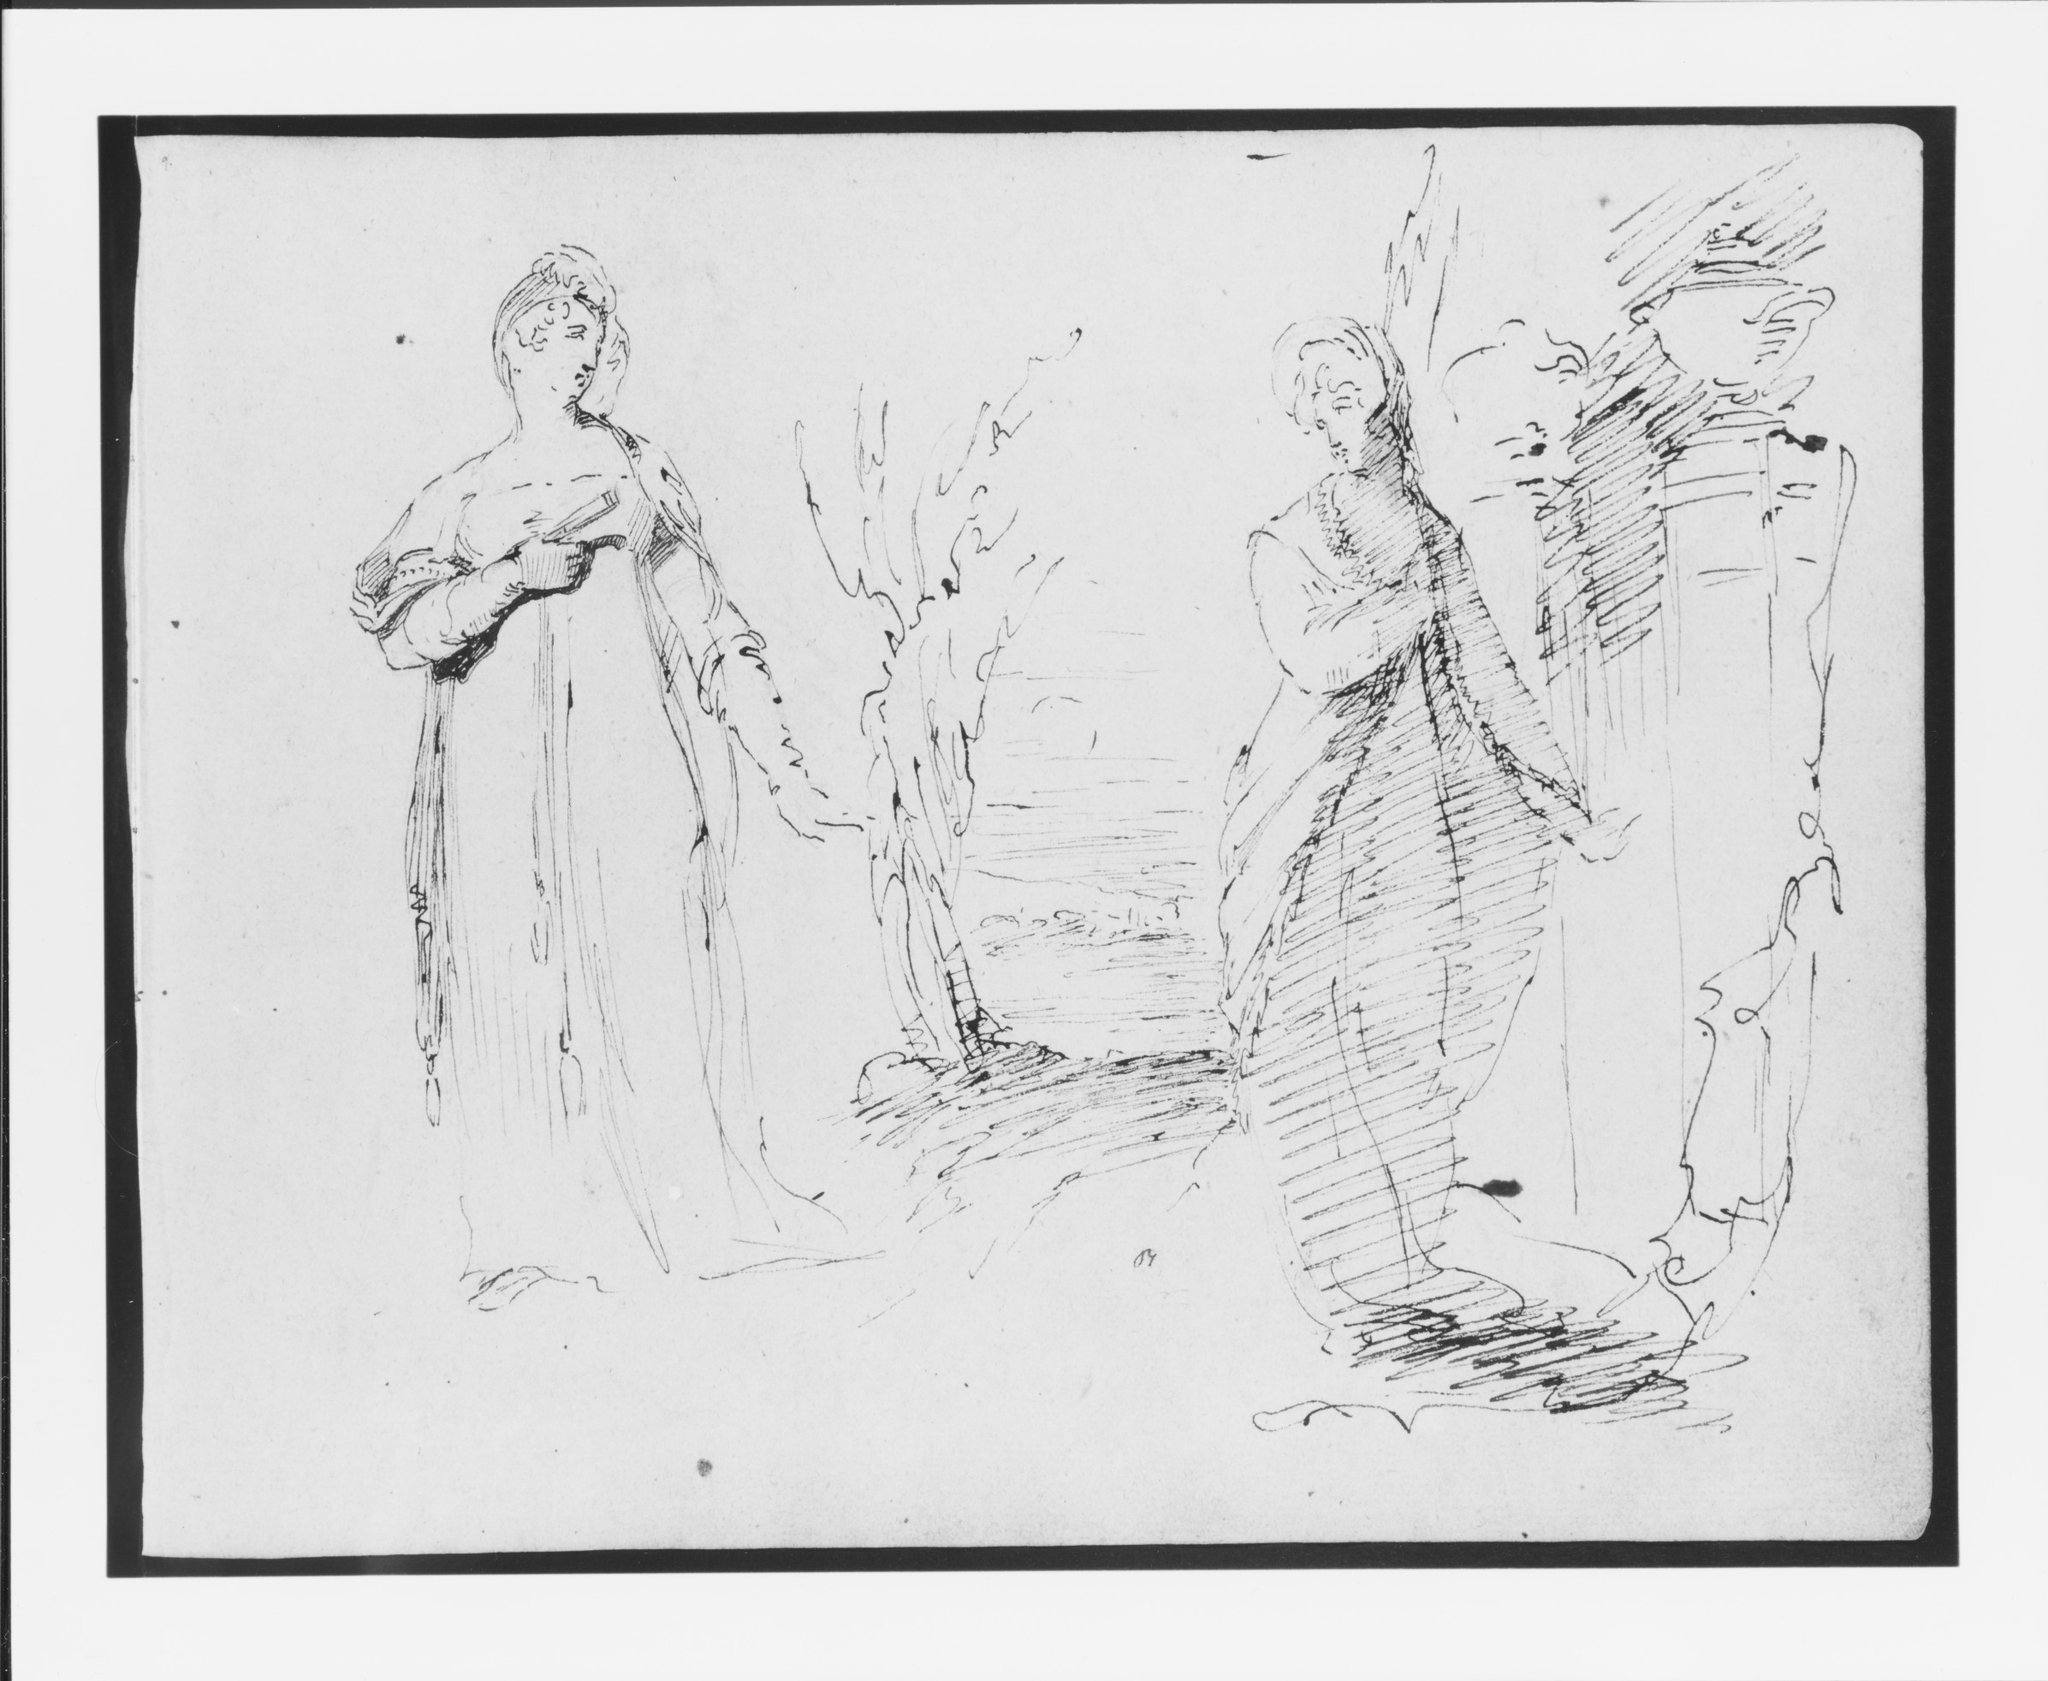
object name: drawing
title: Two Standing Women Flanking an Opening onto a Landscape, Two Pedistals with Urns at Right (from Sketchbook)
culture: american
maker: thomas sully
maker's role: artist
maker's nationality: american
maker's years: 1783-1872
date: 1810-1820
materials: ink, paper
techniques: wash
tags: women